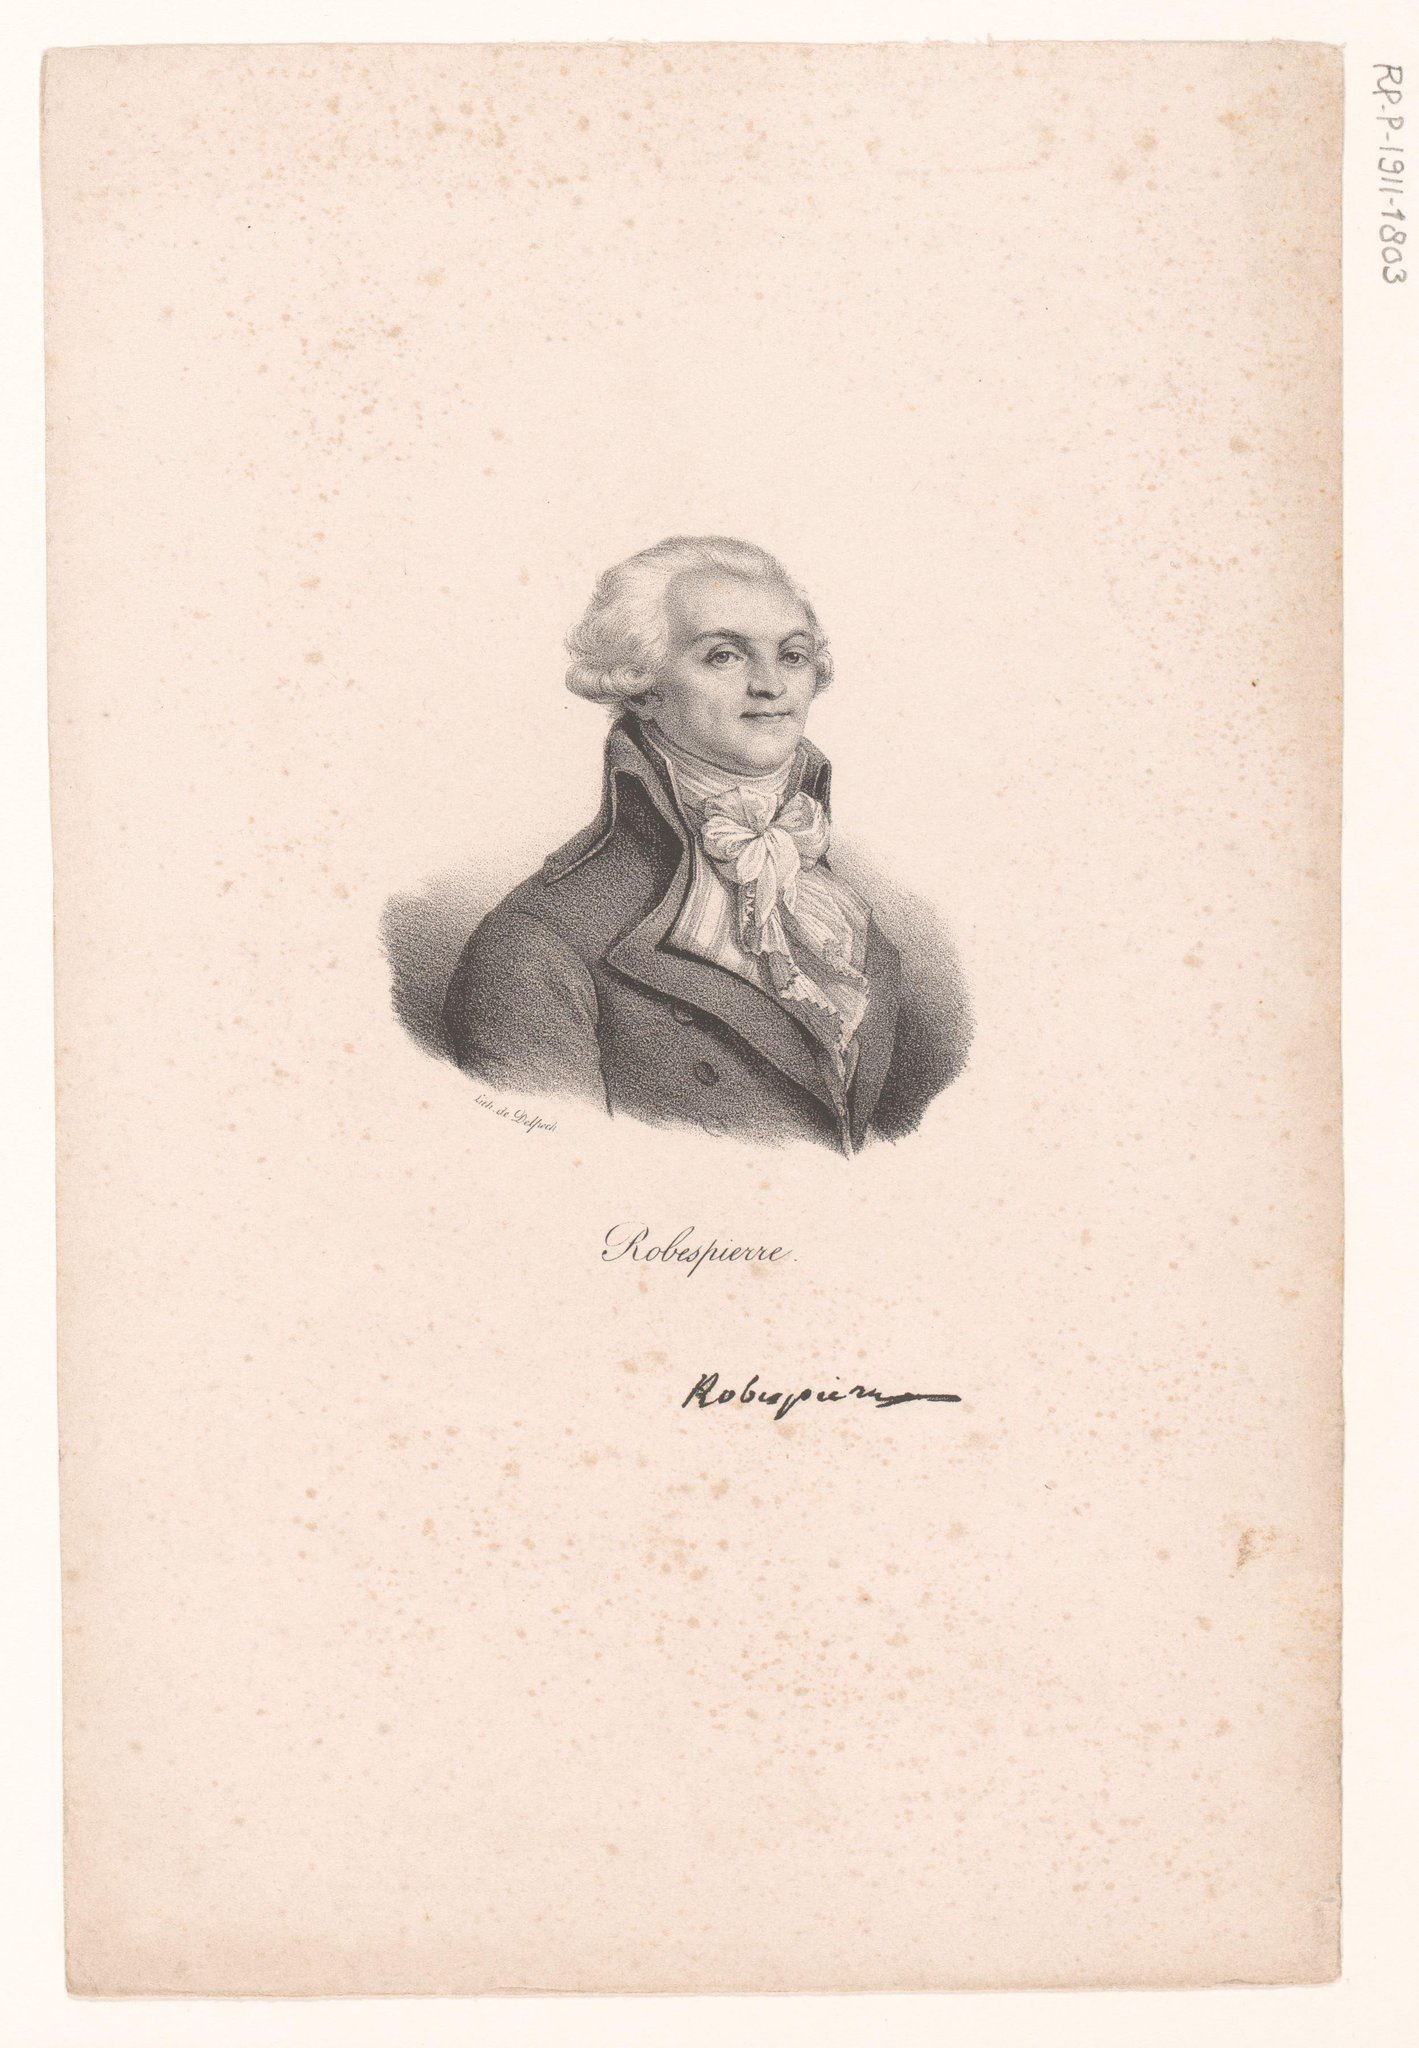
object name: print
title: Robespierre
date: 1818-1842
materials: paper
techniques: lithograph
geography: paris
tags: paris, historical persons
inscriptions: collector's mark: Lugt 2228a